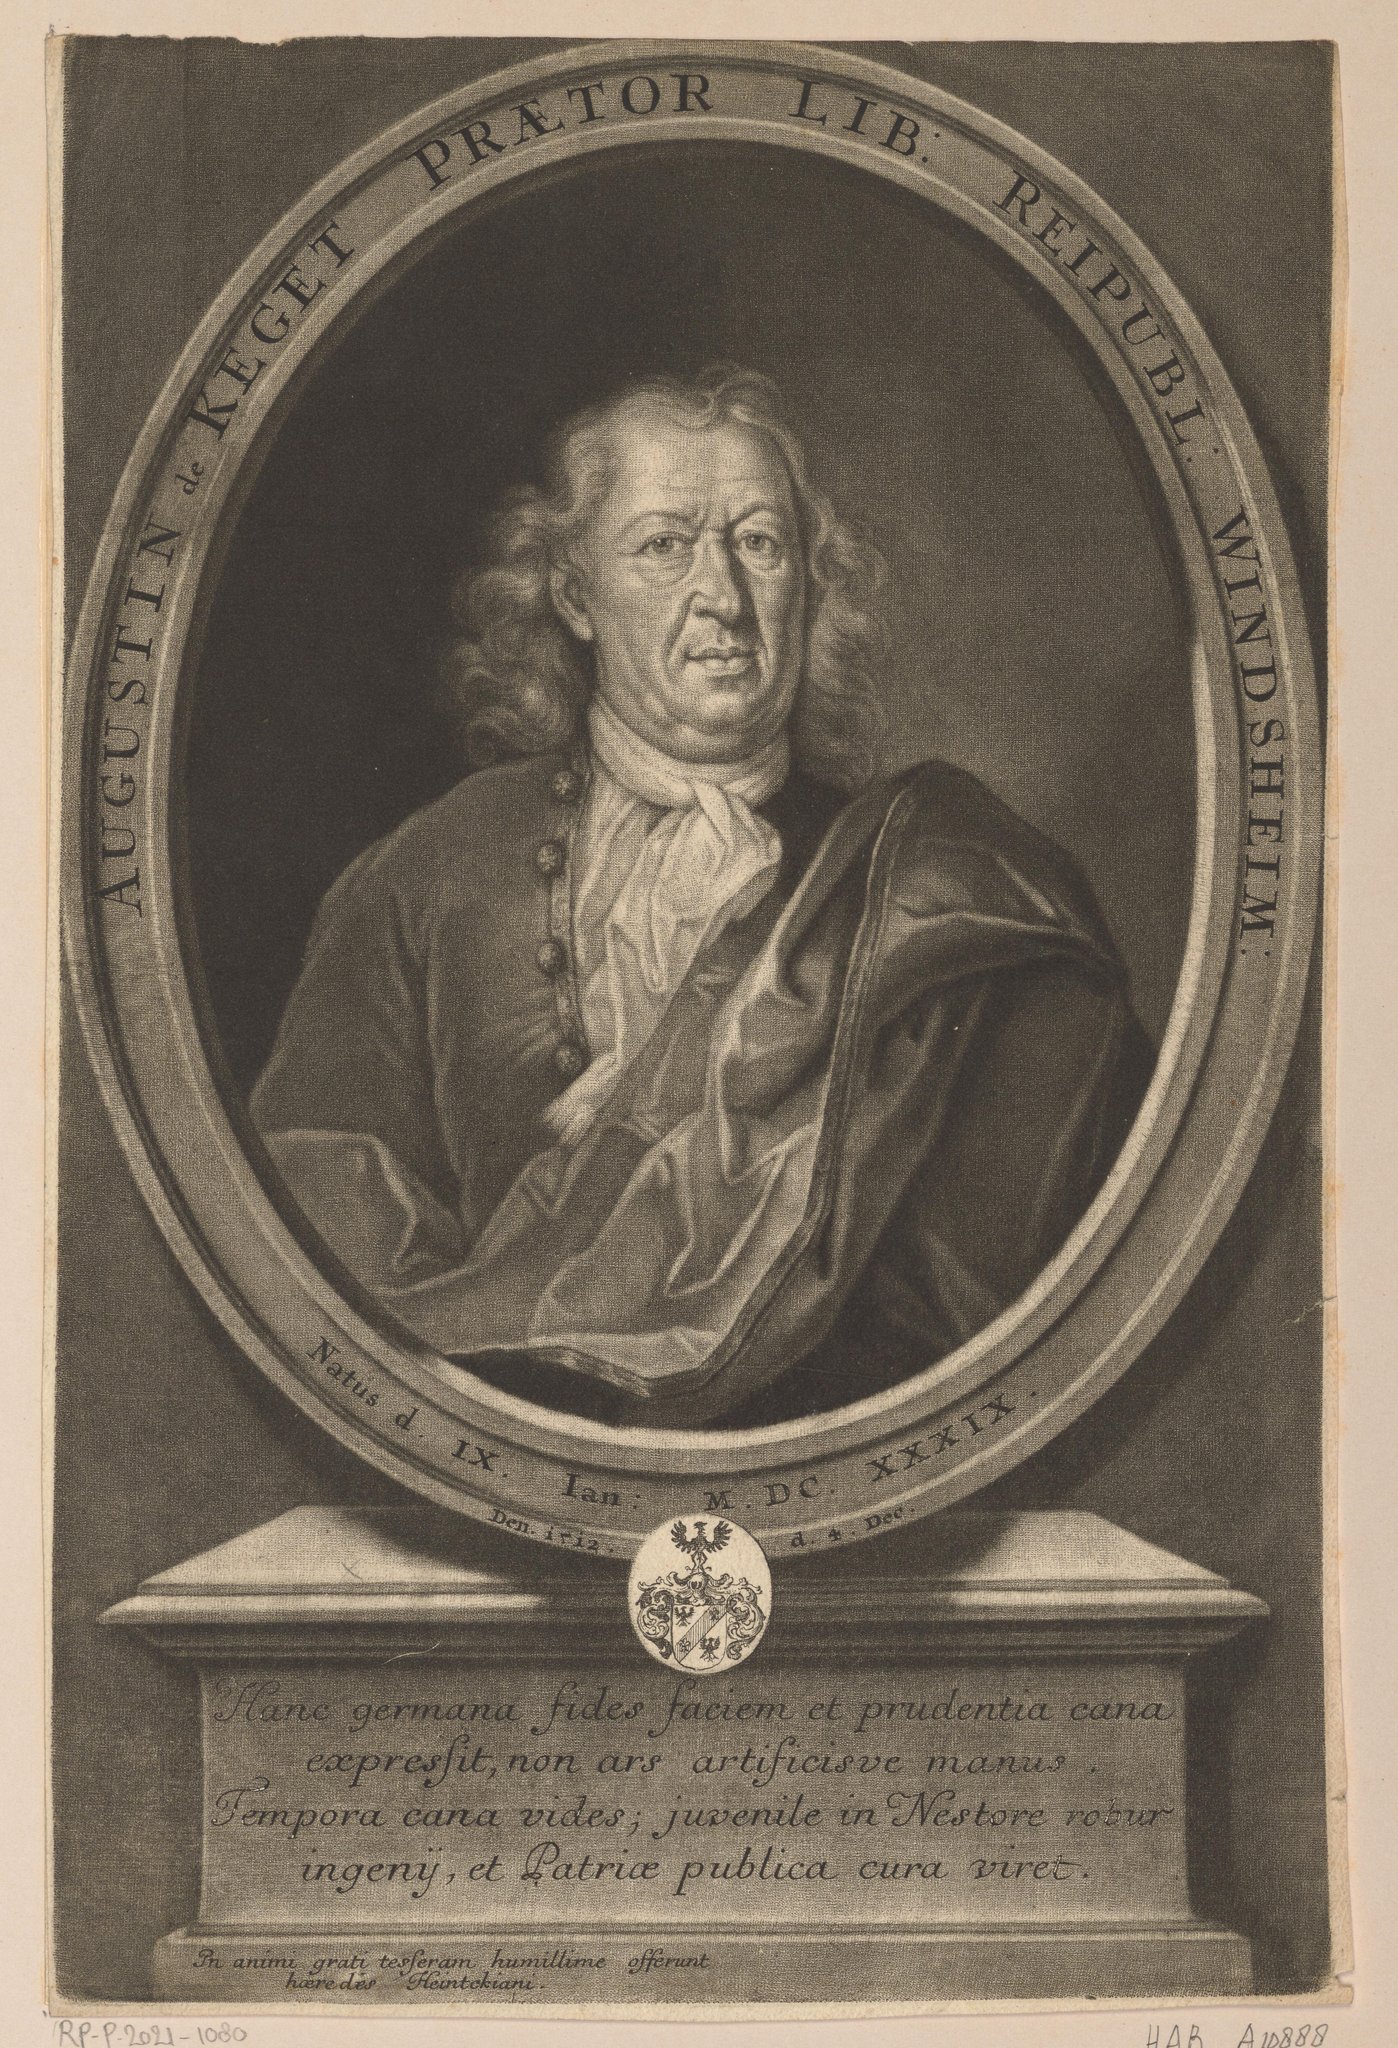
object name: print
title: Portret van Augustin Keget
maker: Anonymous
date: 1712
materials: paper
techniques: engraving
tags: politician, historical persons, armorial bearing, heraldry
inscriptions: date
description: Onder het portret zijn wapenschild en onder het wapenschild een vierregelig vers.